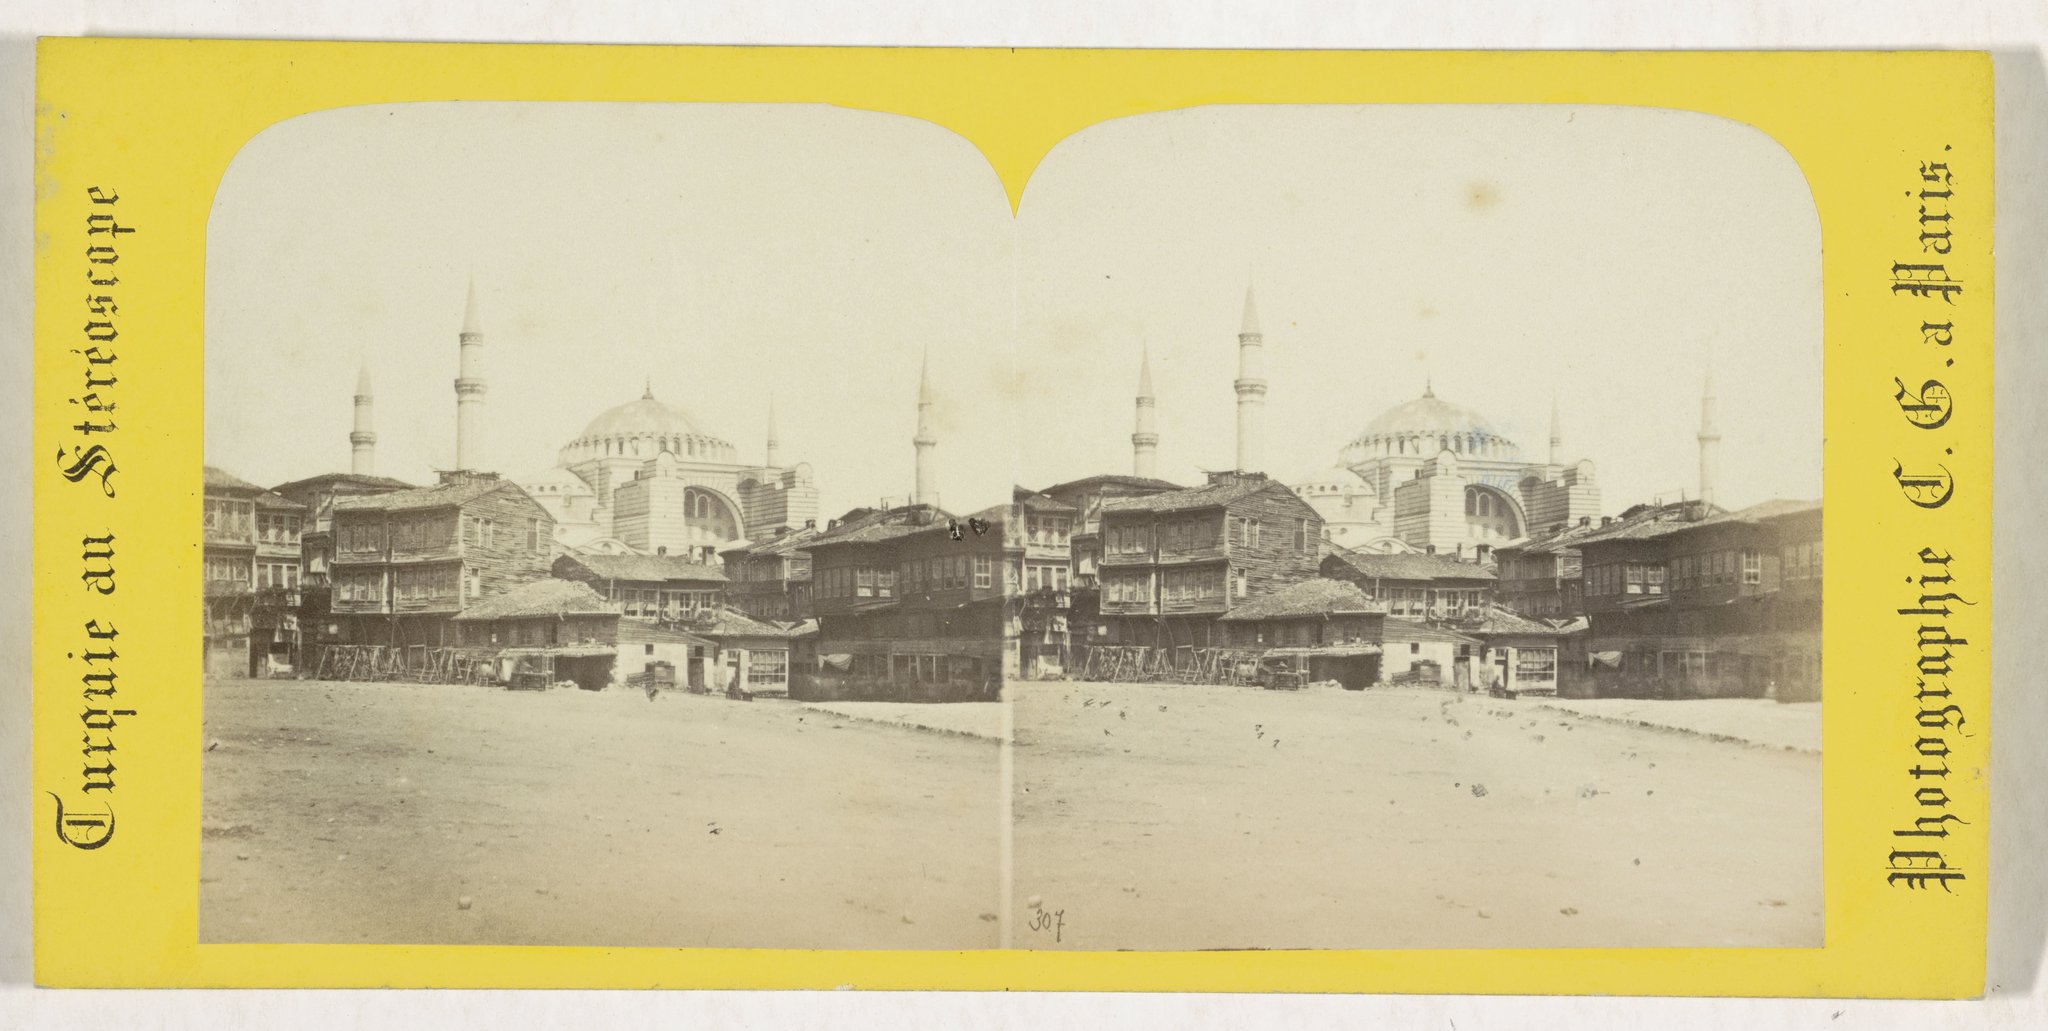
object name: stereograph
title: Gezicht op de Hagia Sophia vanaf het Sultanahmet Meydani plein in Istanboel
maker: charles gaudin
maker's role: publisher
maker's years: 1825-1905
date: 1861-1870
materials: cardboard, paper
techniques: albumen print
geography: hippodroom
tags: square, place, circus, etc., temple, shrine ~ islam, mohammedanism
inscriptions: number: ‘307’